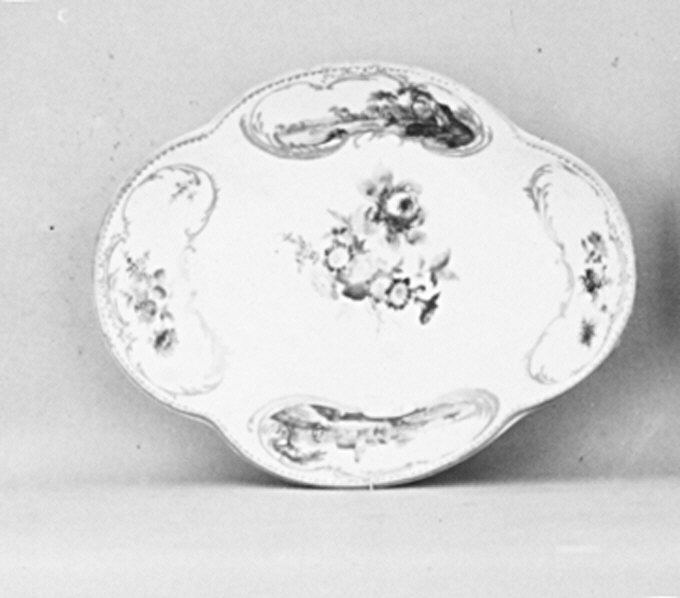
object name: tray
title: Small tray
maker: meissen manufactory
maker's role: manufactory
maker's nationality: german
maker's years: 1710-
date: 1750-1760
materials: hard paste porcelain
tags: flowers